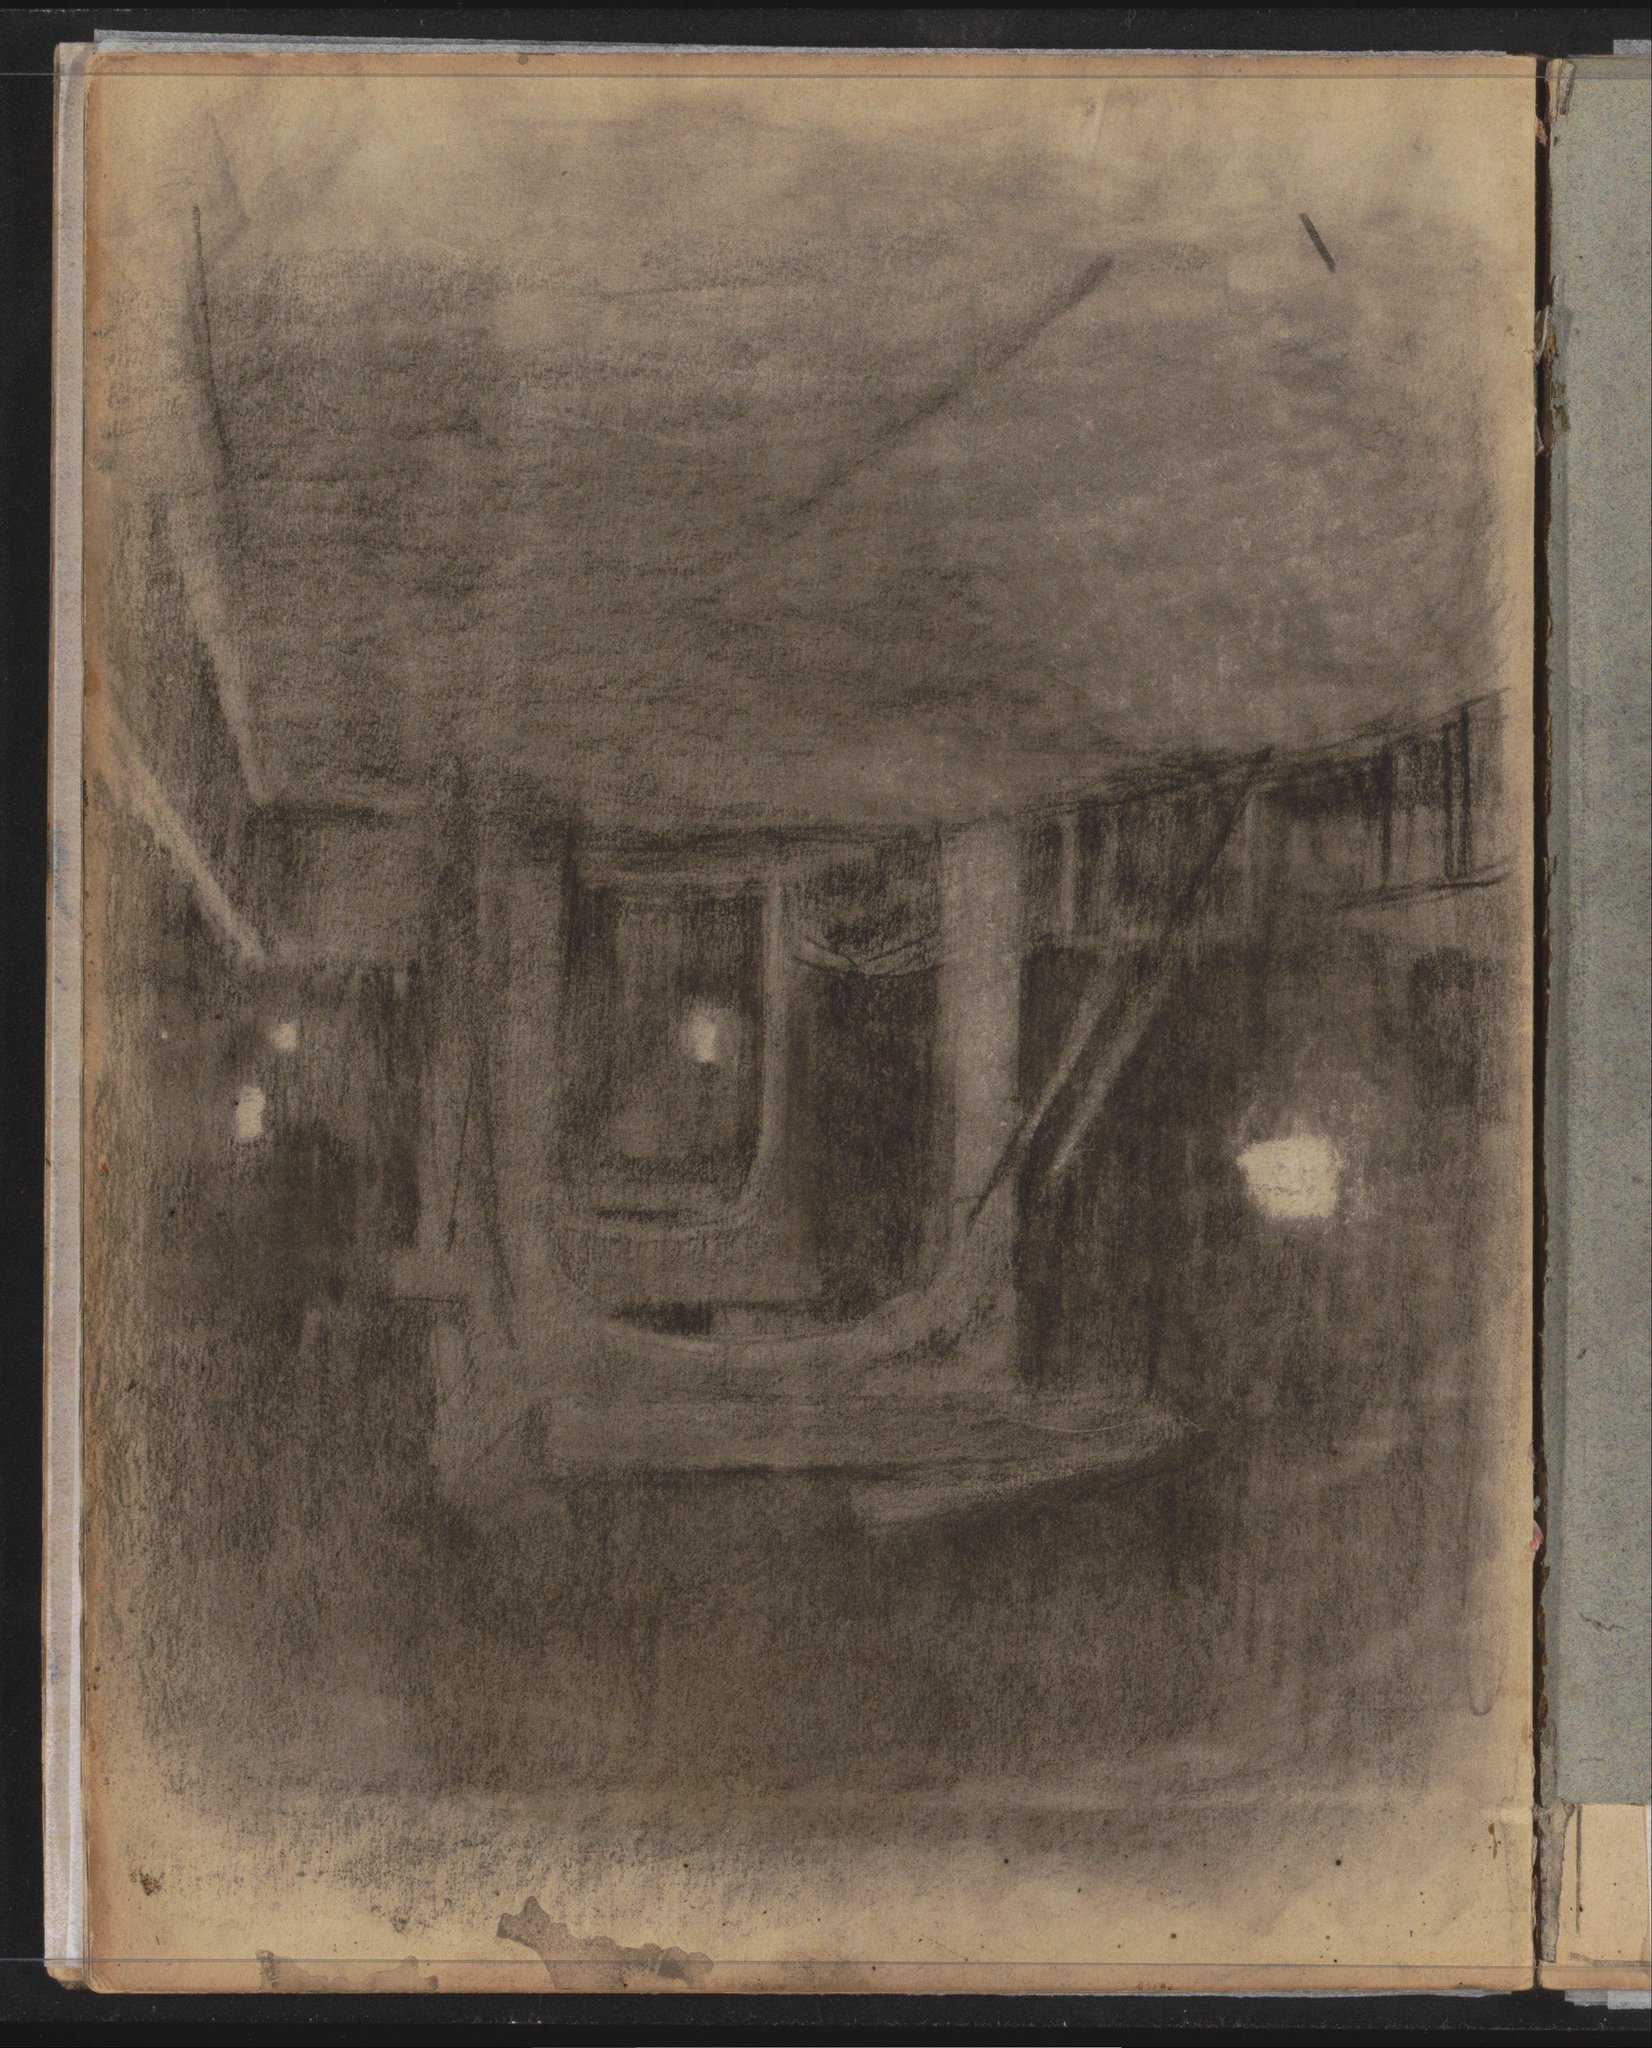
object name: sketchbook leaf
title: Ophaalbrug in Amsterdam, mogelijk bij de Zandhoek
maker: willem witsen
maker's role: draughtsman, painter, print maker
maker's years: 1860-1923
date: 1887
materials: chalk, paper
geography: amsterdam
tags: bridge in city across river, canal, etc.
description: Pagina 38 uit een schetsboek met 29 bladen.